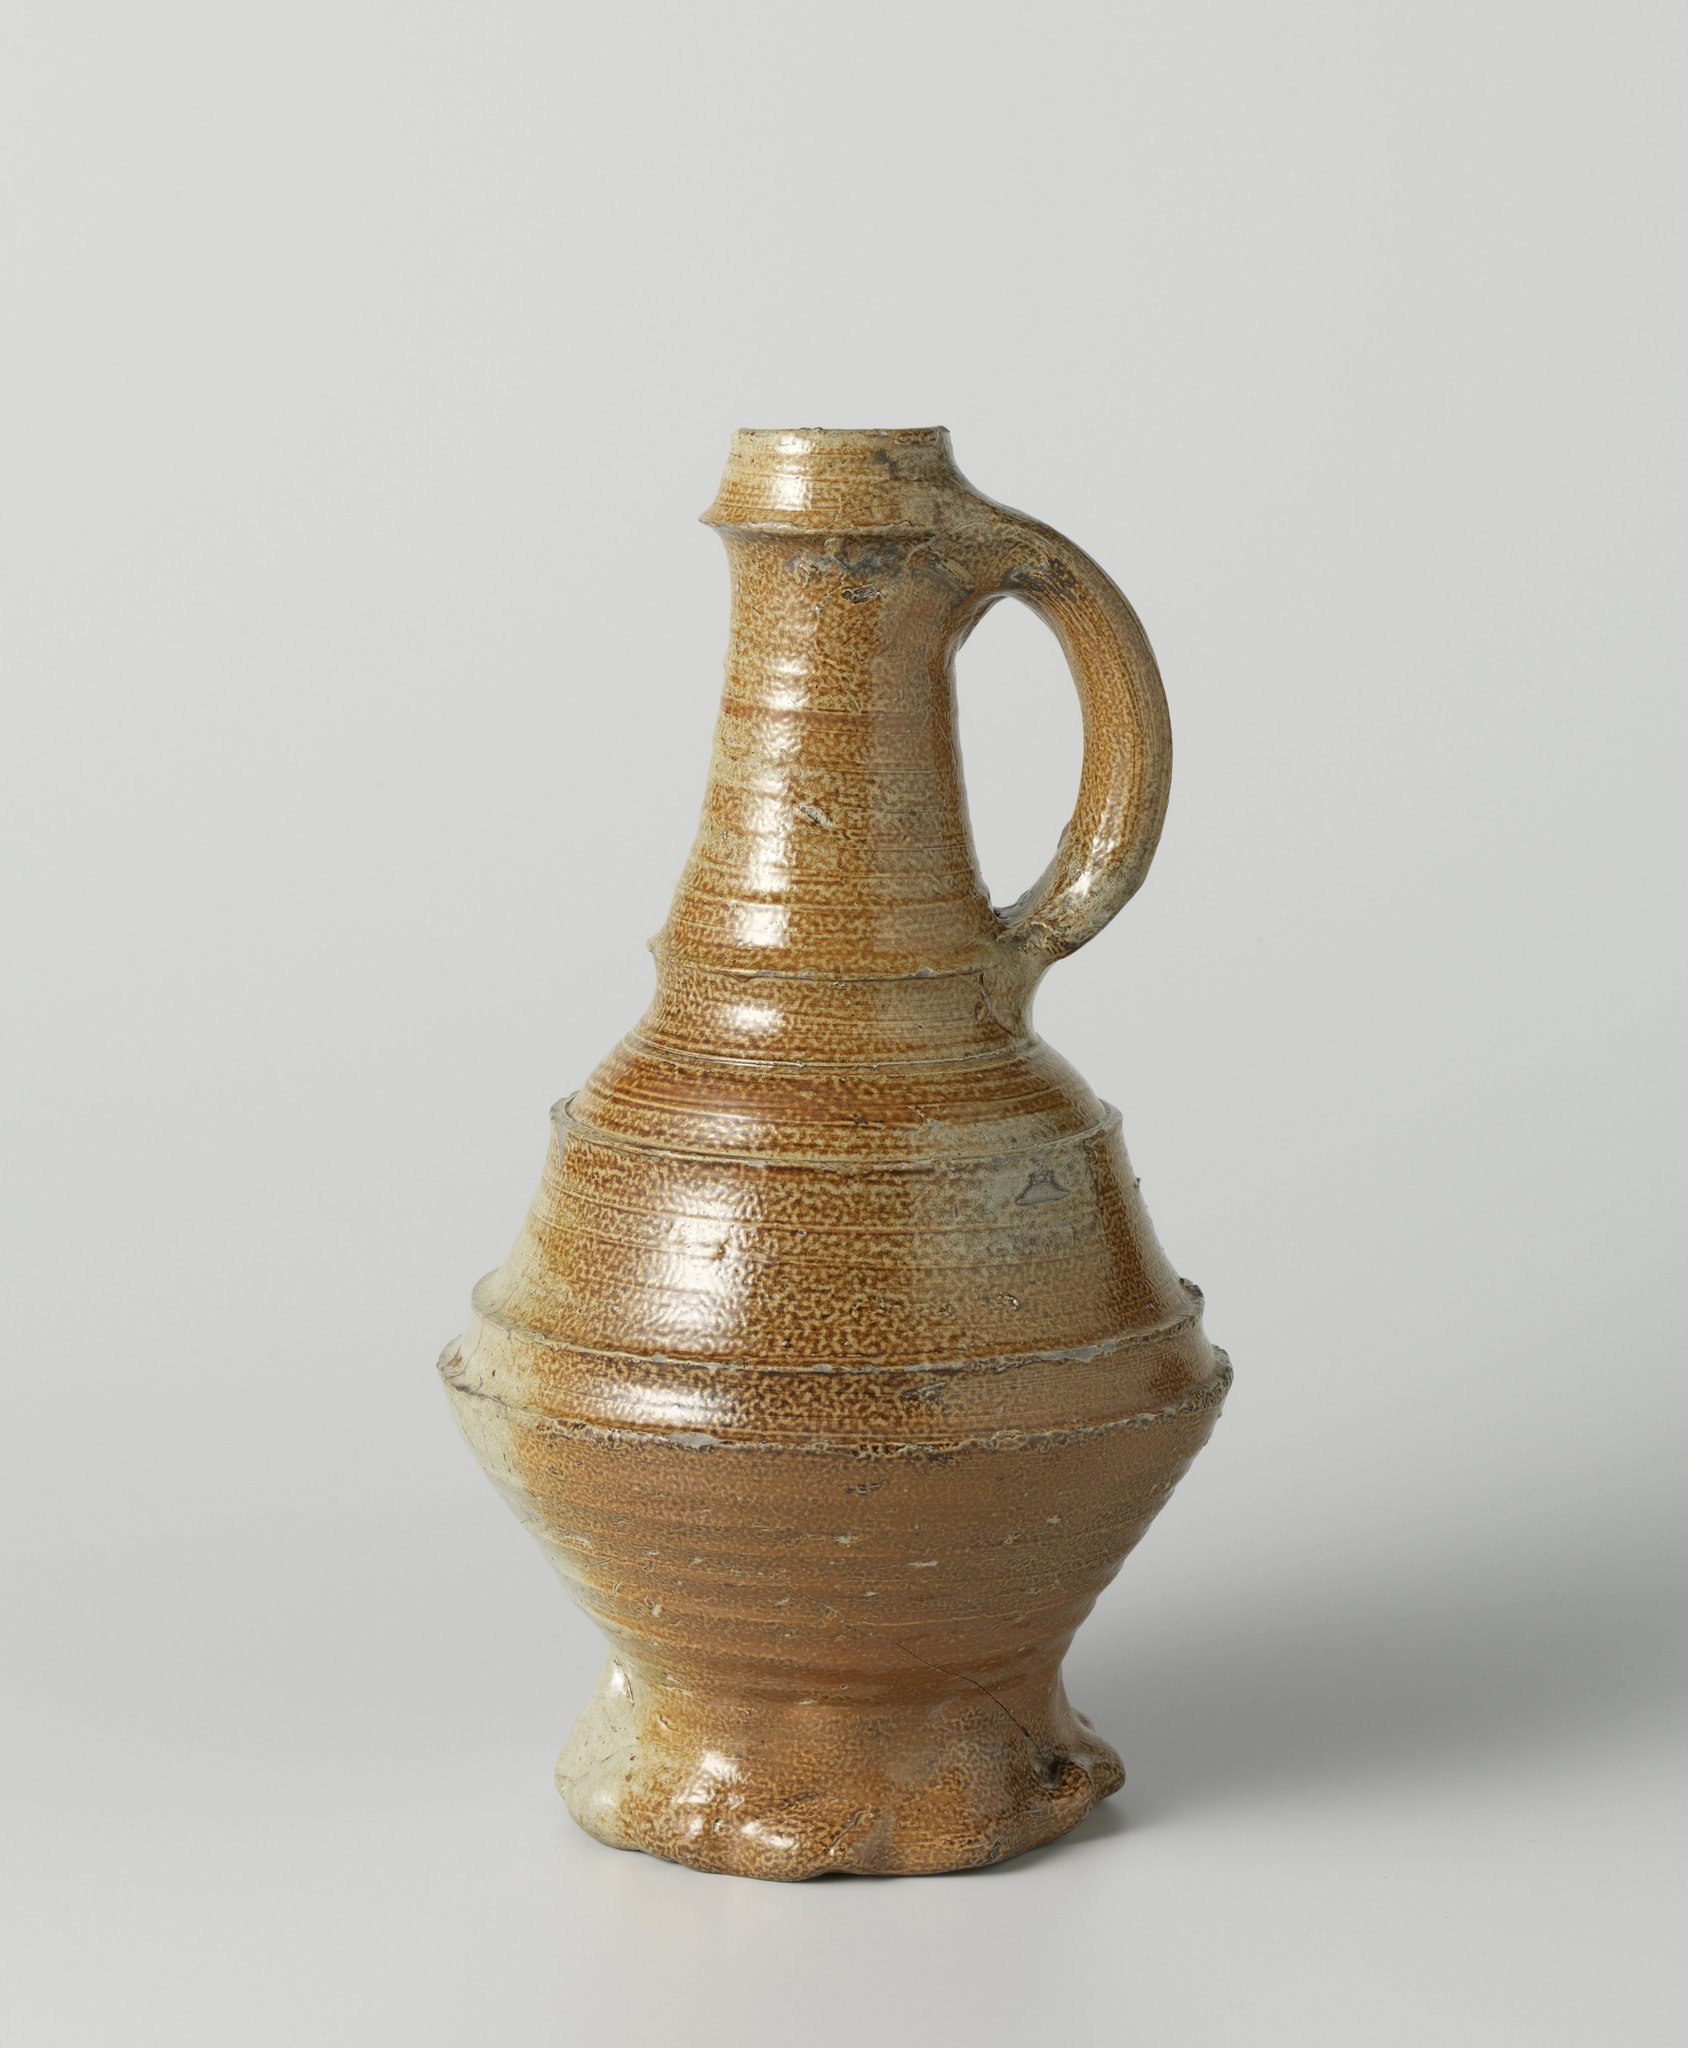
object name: jug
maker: Anonymous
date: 1500-1549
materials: engobe, glaze, stoneware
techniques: firing, forming, turning, vitrification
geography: raeren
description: Kruik van aardewerk op golvende voet met een peervormig lichaam en smalle nek. Het C-vormige oor is bevestigd aan de nek. Bedekt met een bruine engobe. De kruik is versierd met draairingen en profielen. Raeren.